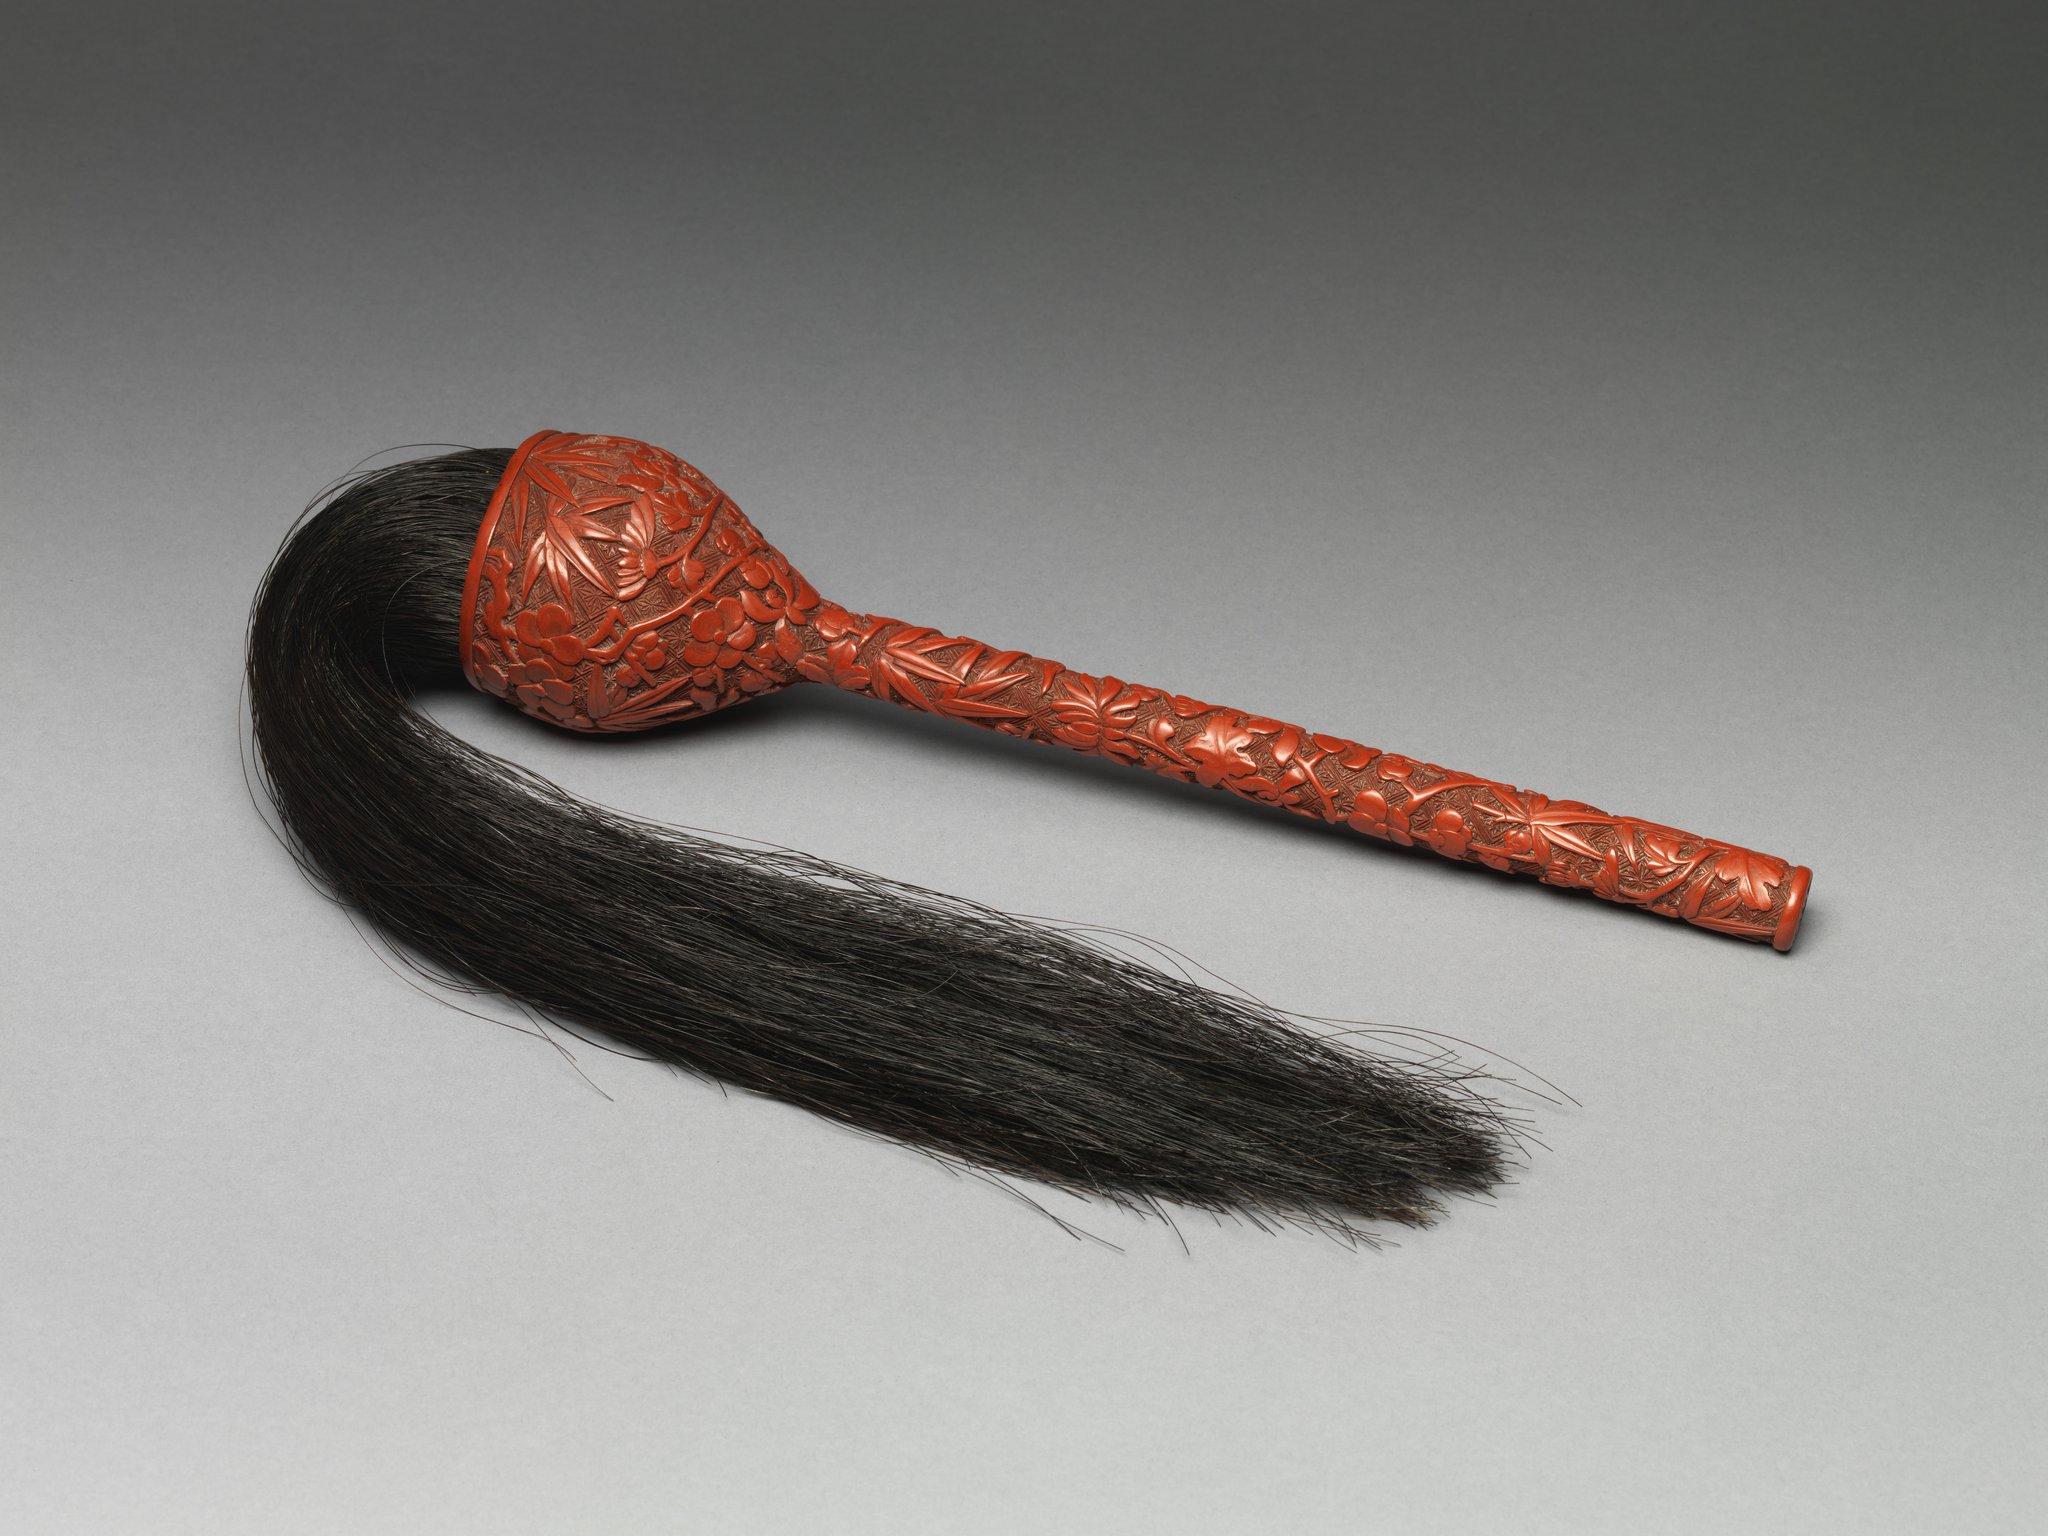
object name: duster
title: Duster with the flowers of four seasons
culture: chinese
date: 1501-1600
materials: lacquer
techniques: carving